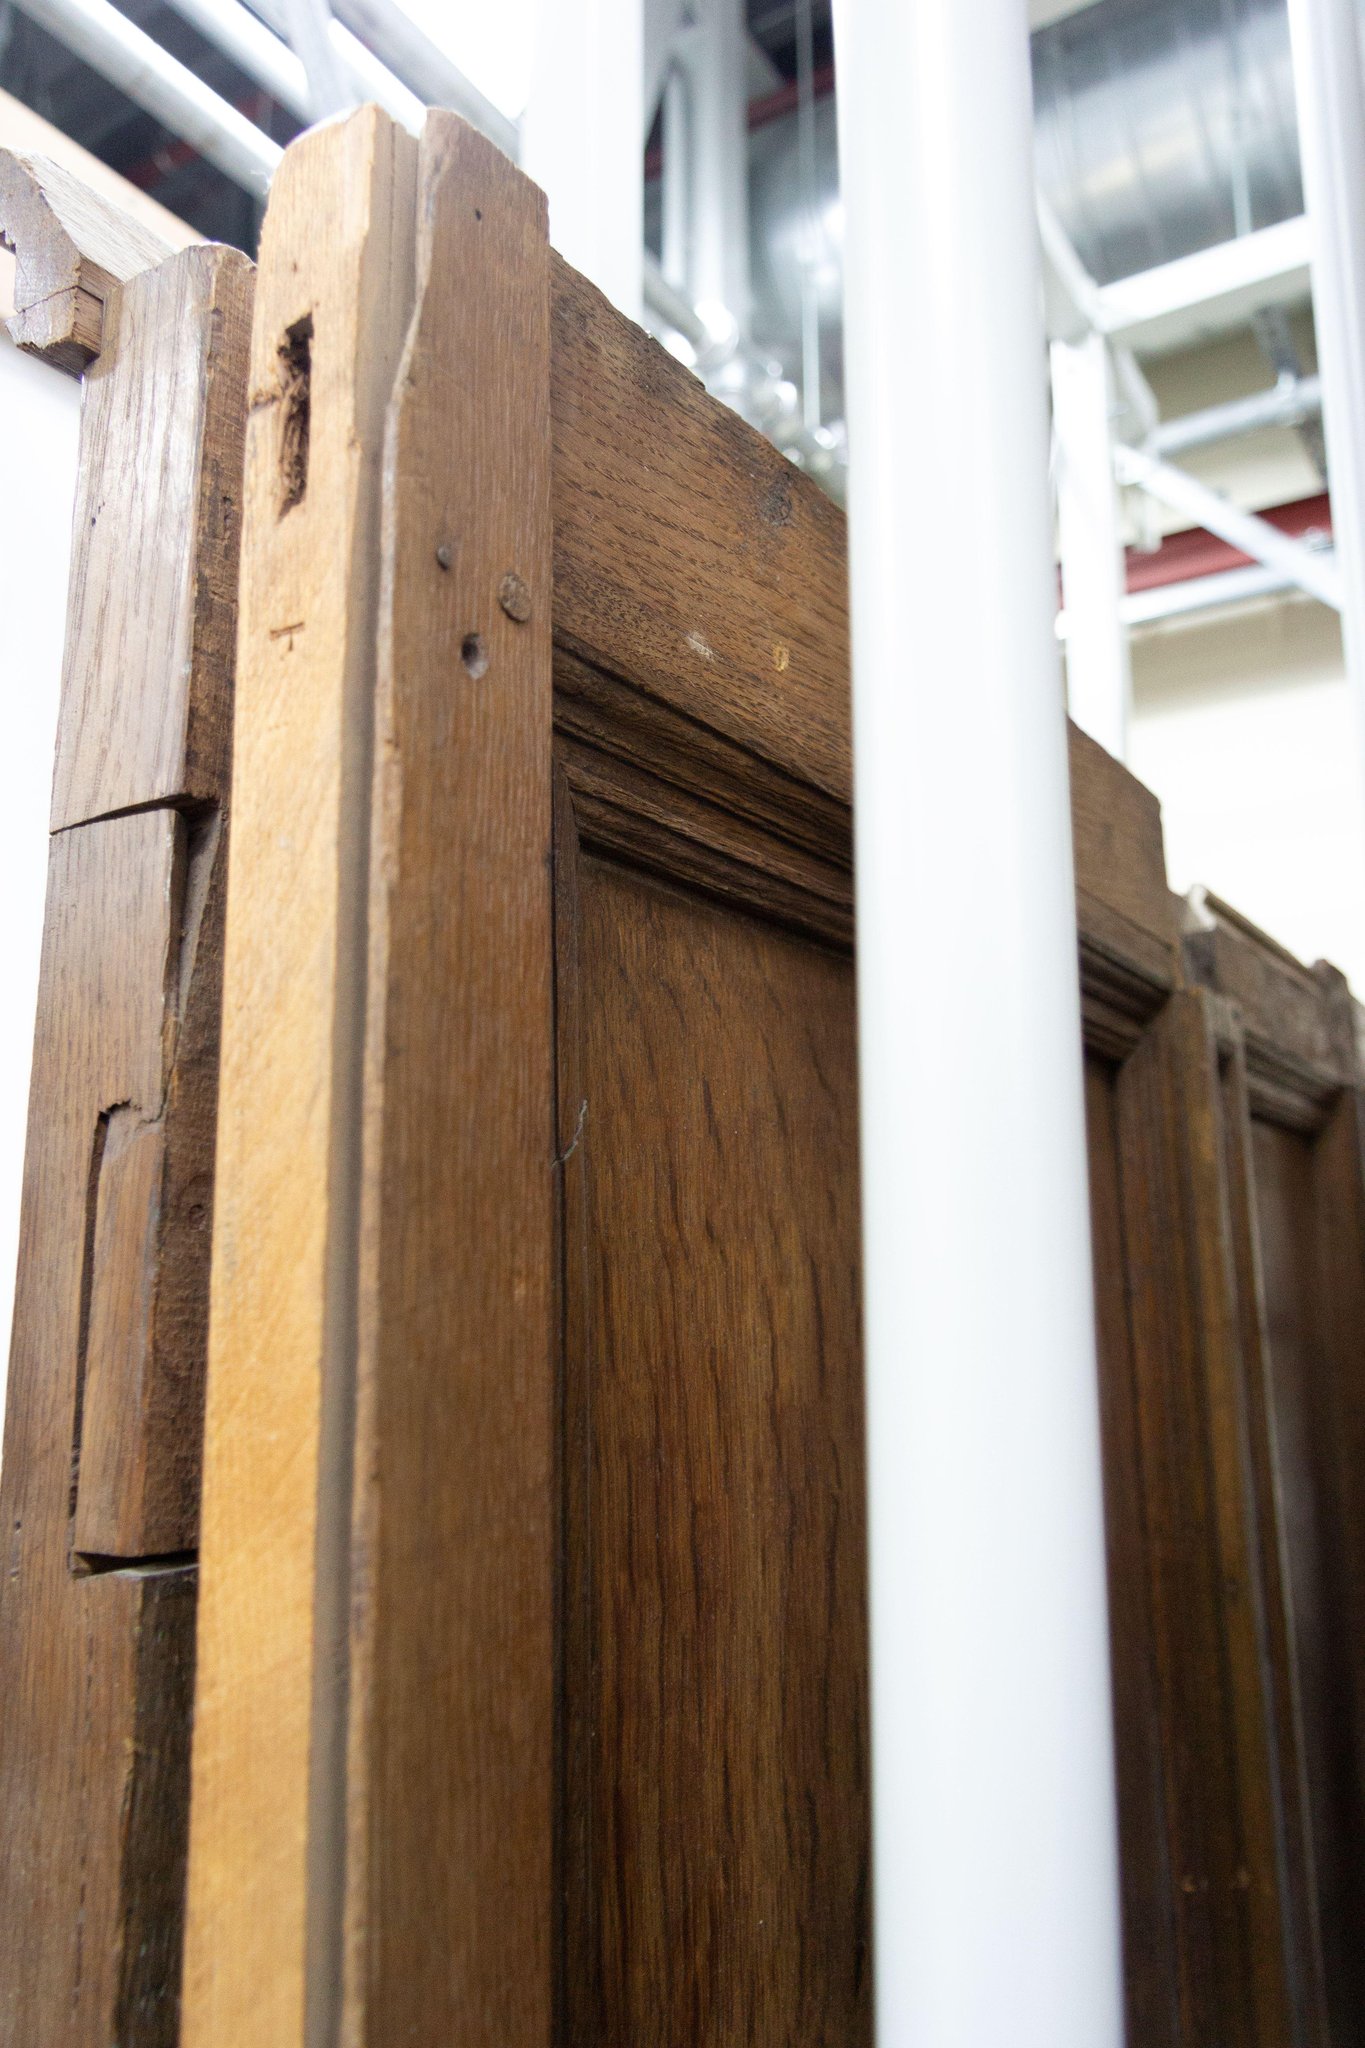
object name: architectural element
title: Schot van een betimmering waarvan de bovendorpels boven de panelen zijn versierd met symmetrische bladranken met een vaas, cartouche of bladornament. Afkomstig uit het Huis van Maarten van Rossum te Zaltbommel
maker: Anonymous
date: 1535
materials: wood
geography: northern netherlands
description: Schot van een betimmering van eikenhout, door stijlen en regels verdeeld in vakken. Het schot bestaat uit een paar smalle panelen in het midden, met een paar brede ter weerszijden. De stijlen en bovendorpels zijn uitgegrond. De bovendorpels zijn versierd met symmetrische bladranken met een vaas, cartouche of bladornament als middenstuk; het bovendeel van de middenstijlen met kandelaberornament en rozetten. De panelen zijn vlak. Afkomstig uit het huis van Maarten van Rossum te Zaltbommel.